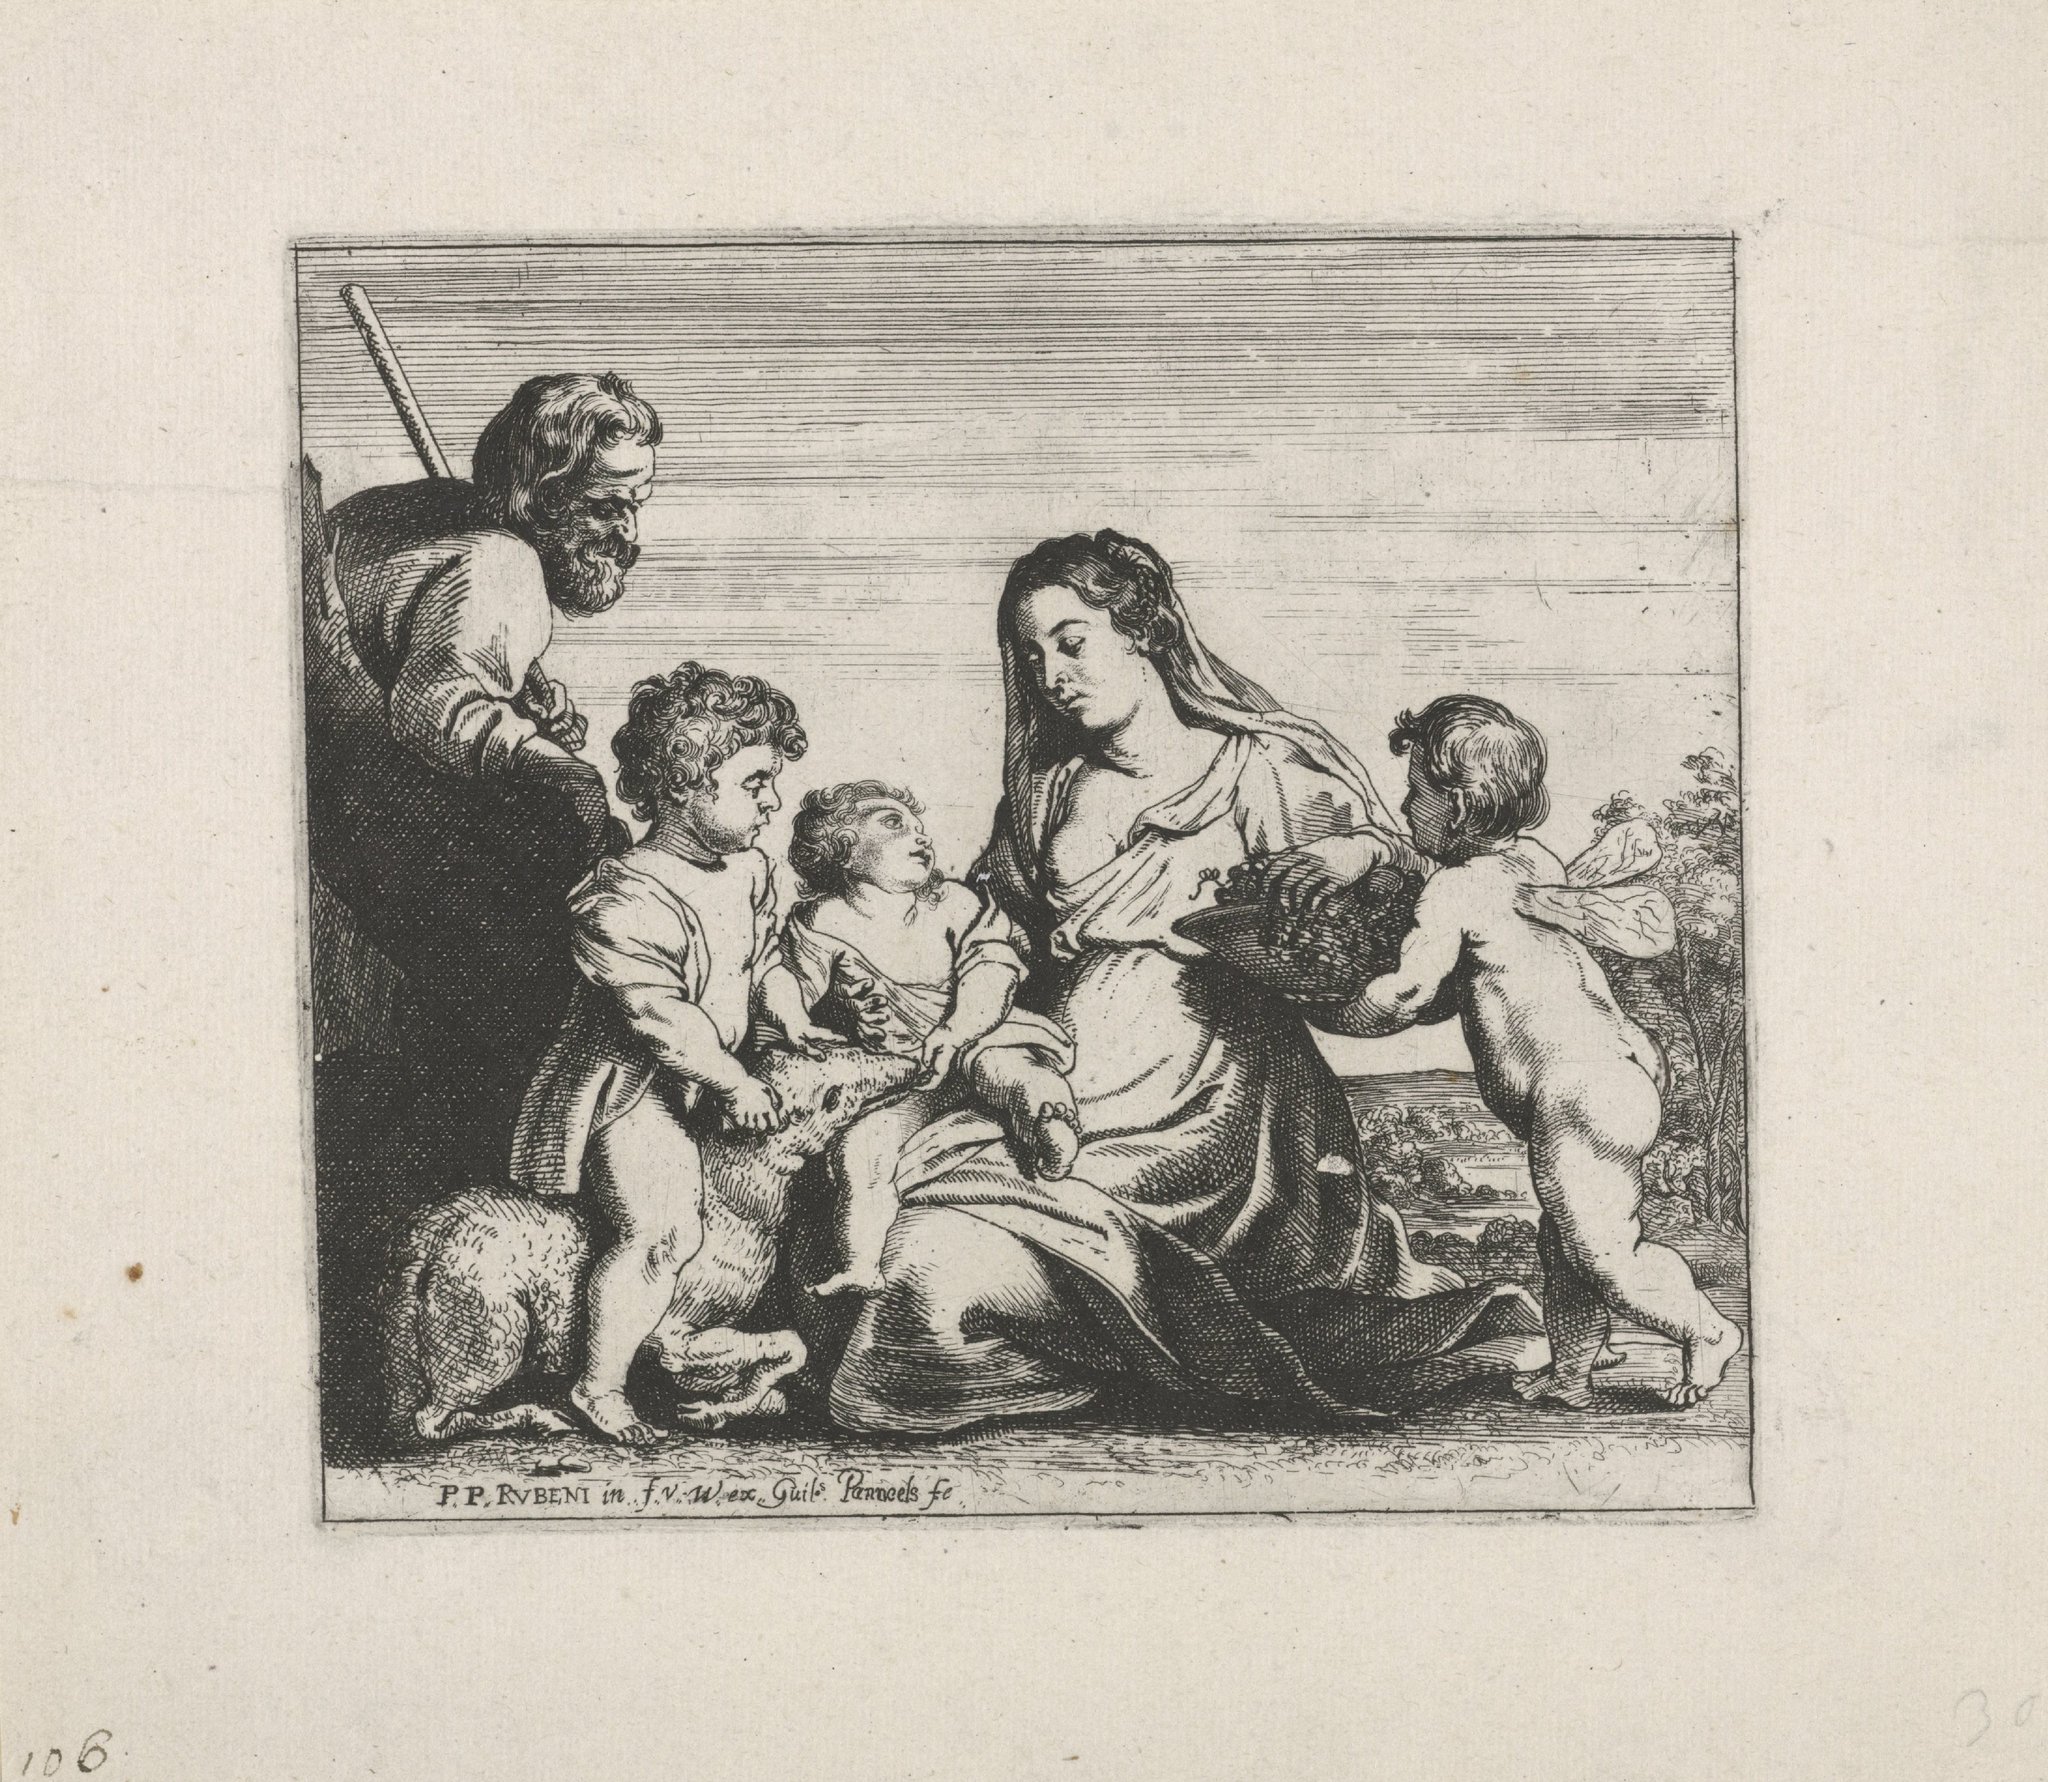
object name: print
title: De Heilige Familie met Johannes de Doper en een engel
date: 1610-1634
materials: paper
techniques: engraving, etching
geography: antwerp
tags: holy family with john the baptist (as child)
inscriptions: inscription: ‘106’, collector's mark: Lugt 240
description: Maria zit op de grond met het Christuskind op haar schoot. Een engel reikt haar een schaal aan. Johannes de Doper zit op zijn lam en Jozef leunt op een boomstronk.